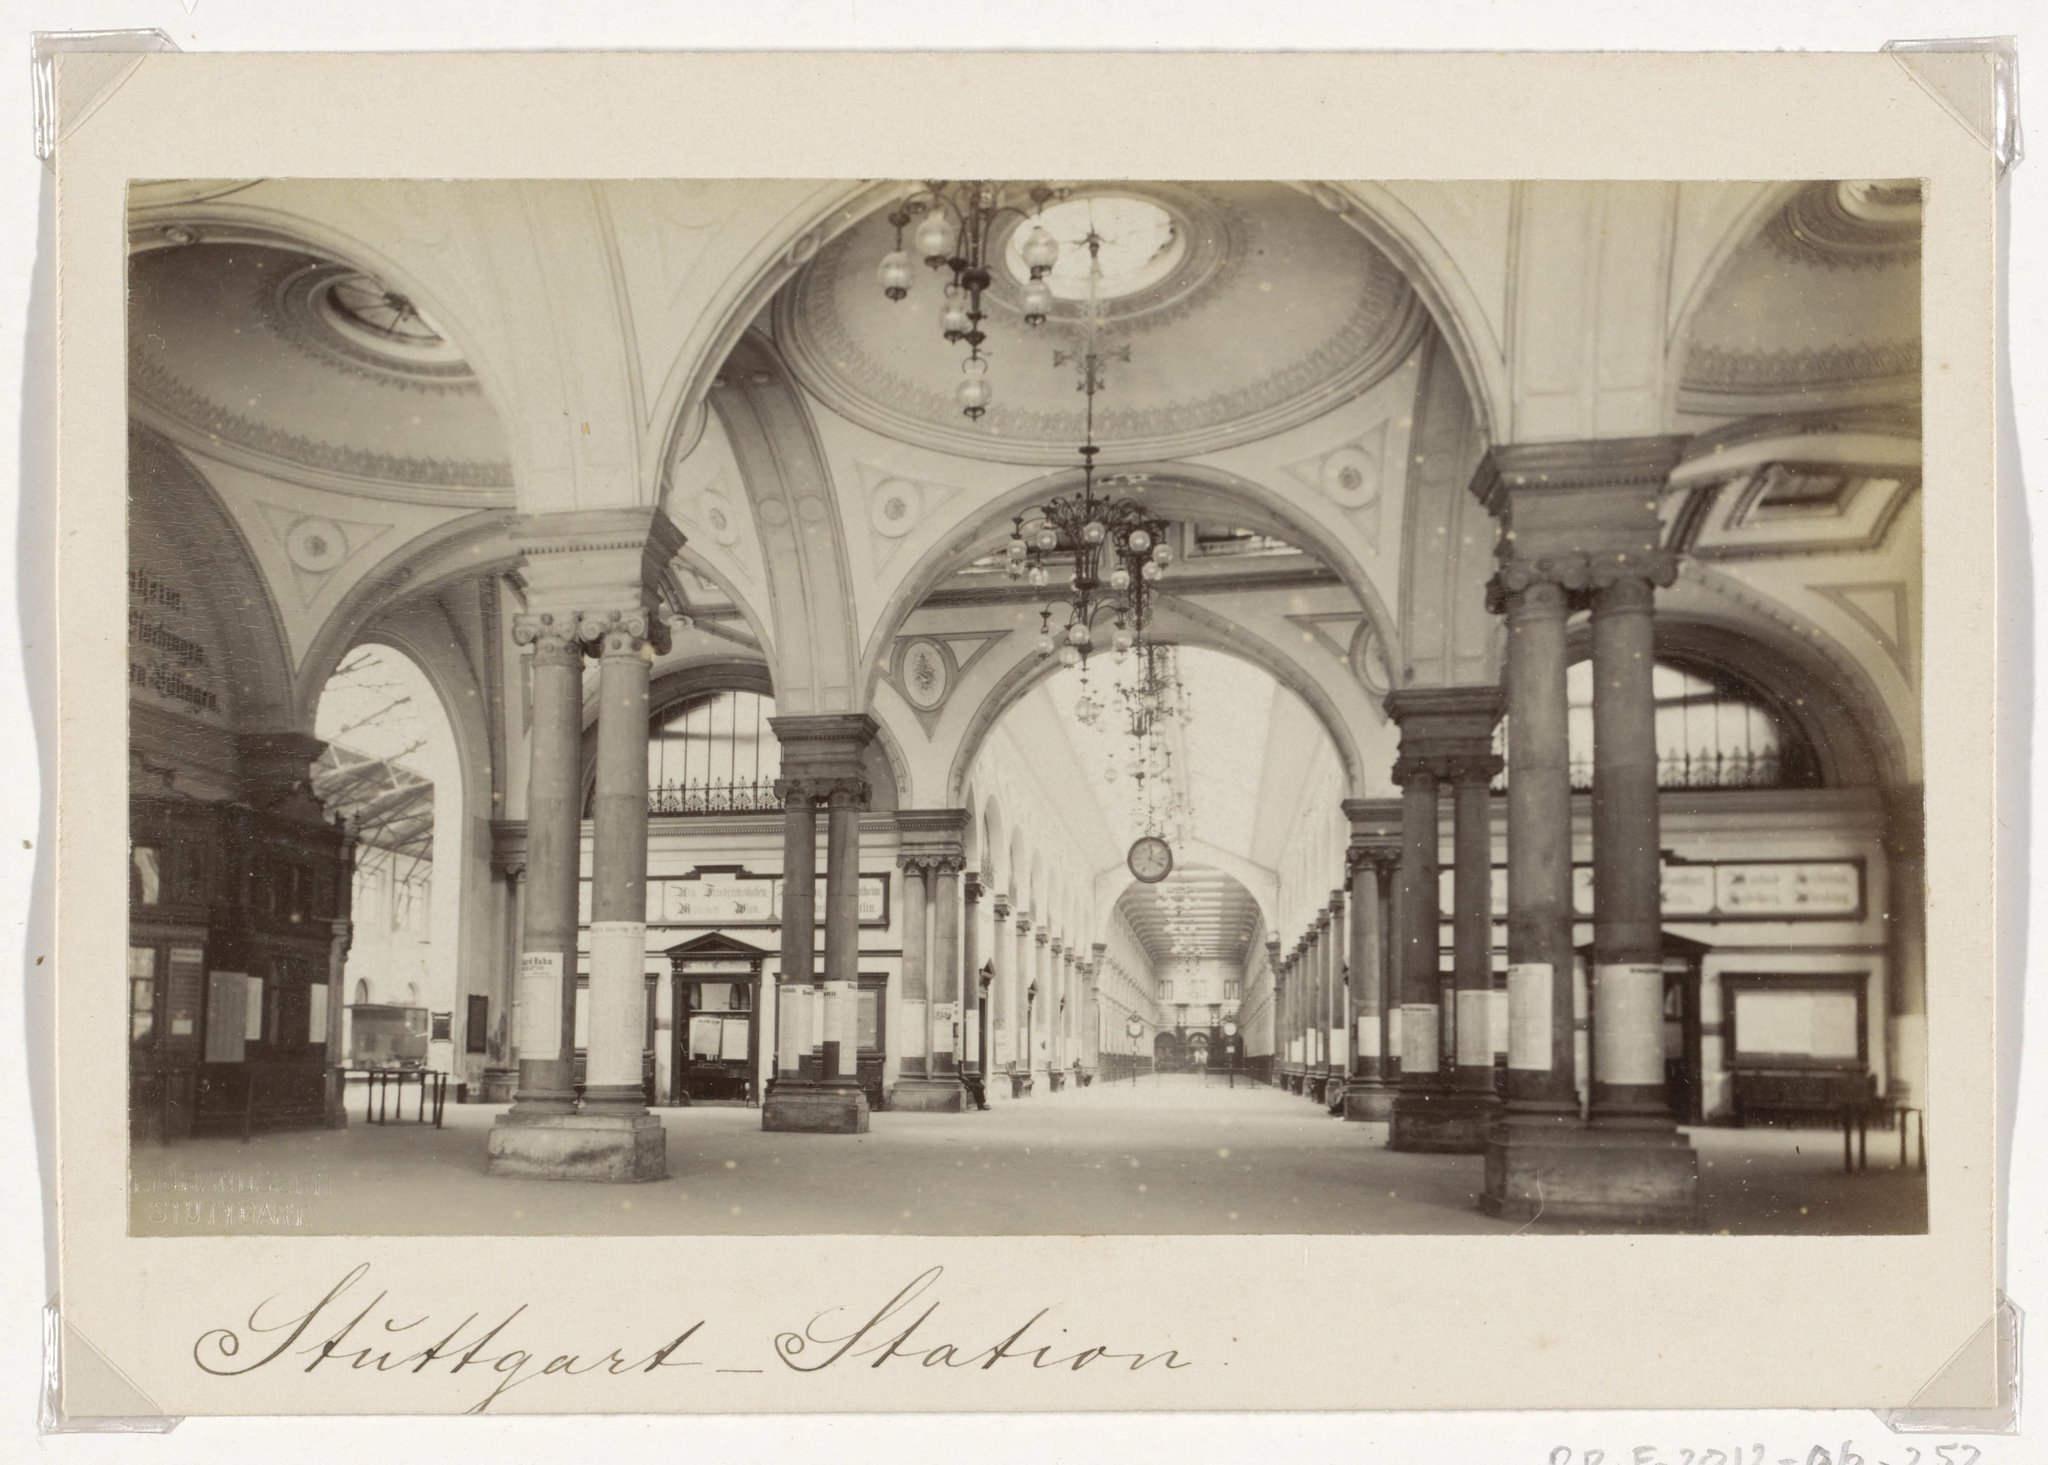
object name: photograph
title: Stüttgart Station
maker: friedrich brandseph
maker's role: fotograaf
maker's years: 1826-1916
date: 1870-1890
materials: cardboard, paper, photographic support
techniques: albumen print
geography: stuttgart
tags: station; shelter (railway, tramway)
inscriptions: check stamp: ‘P. Brandseph Stuttgart’